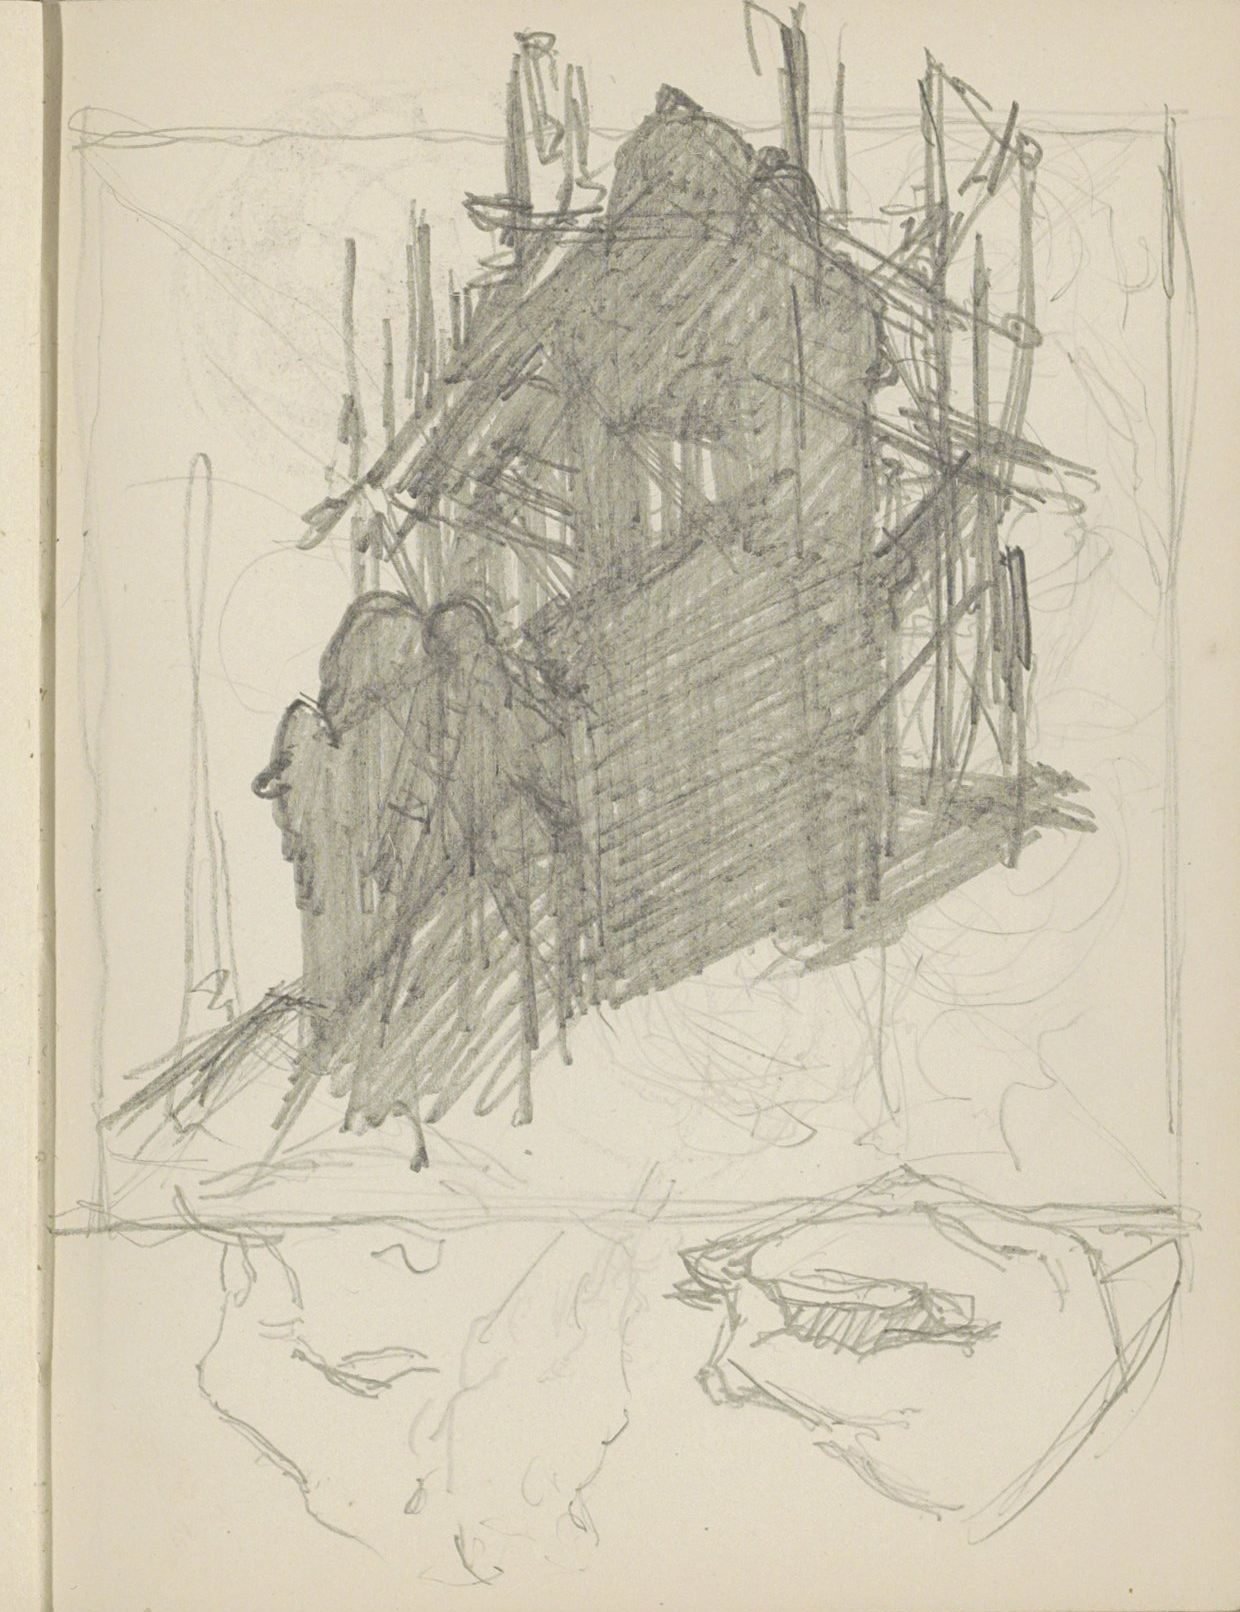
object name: sketchbook leaf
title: Toren in de steigers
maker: reijer stolk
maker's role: draughtsman, print maker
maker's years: 1896-1945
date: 1906-1945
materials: paper, pencil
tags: scaffold (~ building activities), hand, tower (of house or building)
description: Tevens studies van handen. Blad 58 recto uit een schetsboek met 69 bladen.